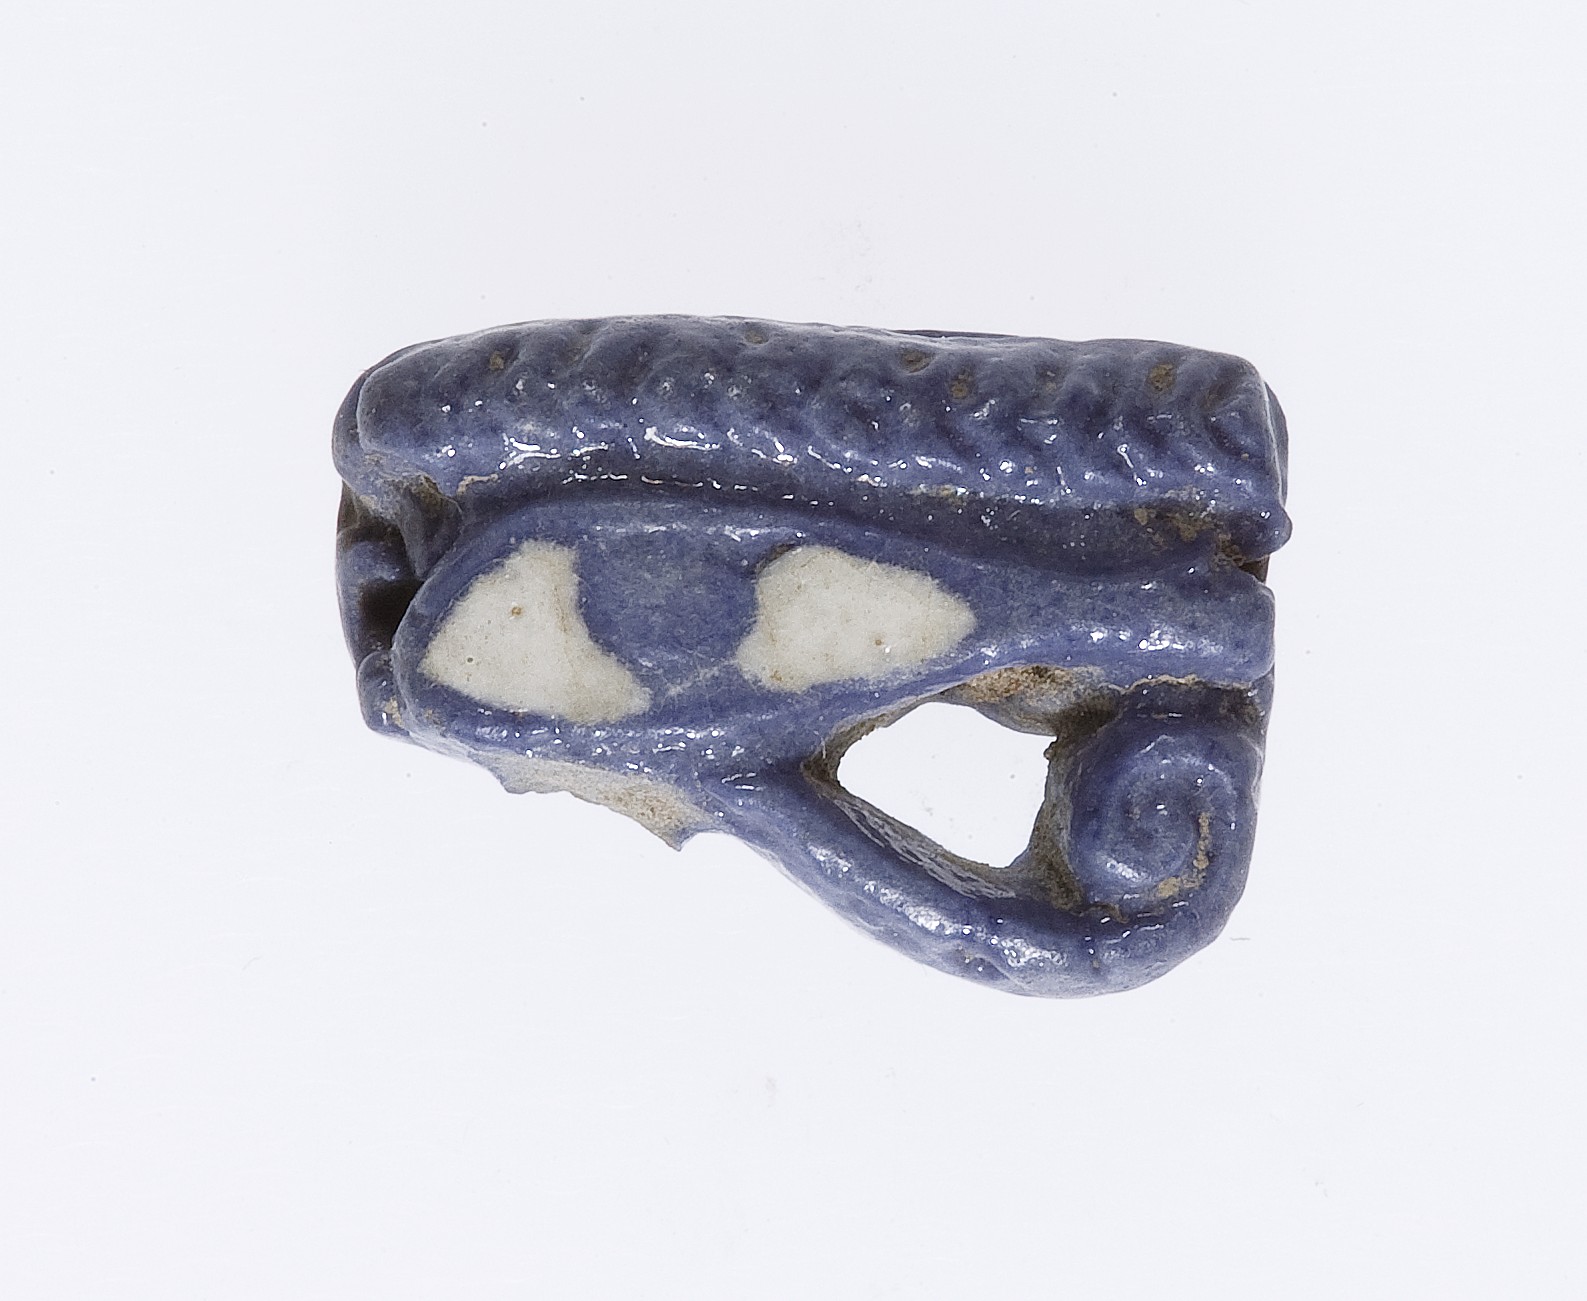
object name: amulet, wedjat eye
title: Wedjat Eye Amulet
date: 1390-1352 BCE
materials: faience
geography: egypt